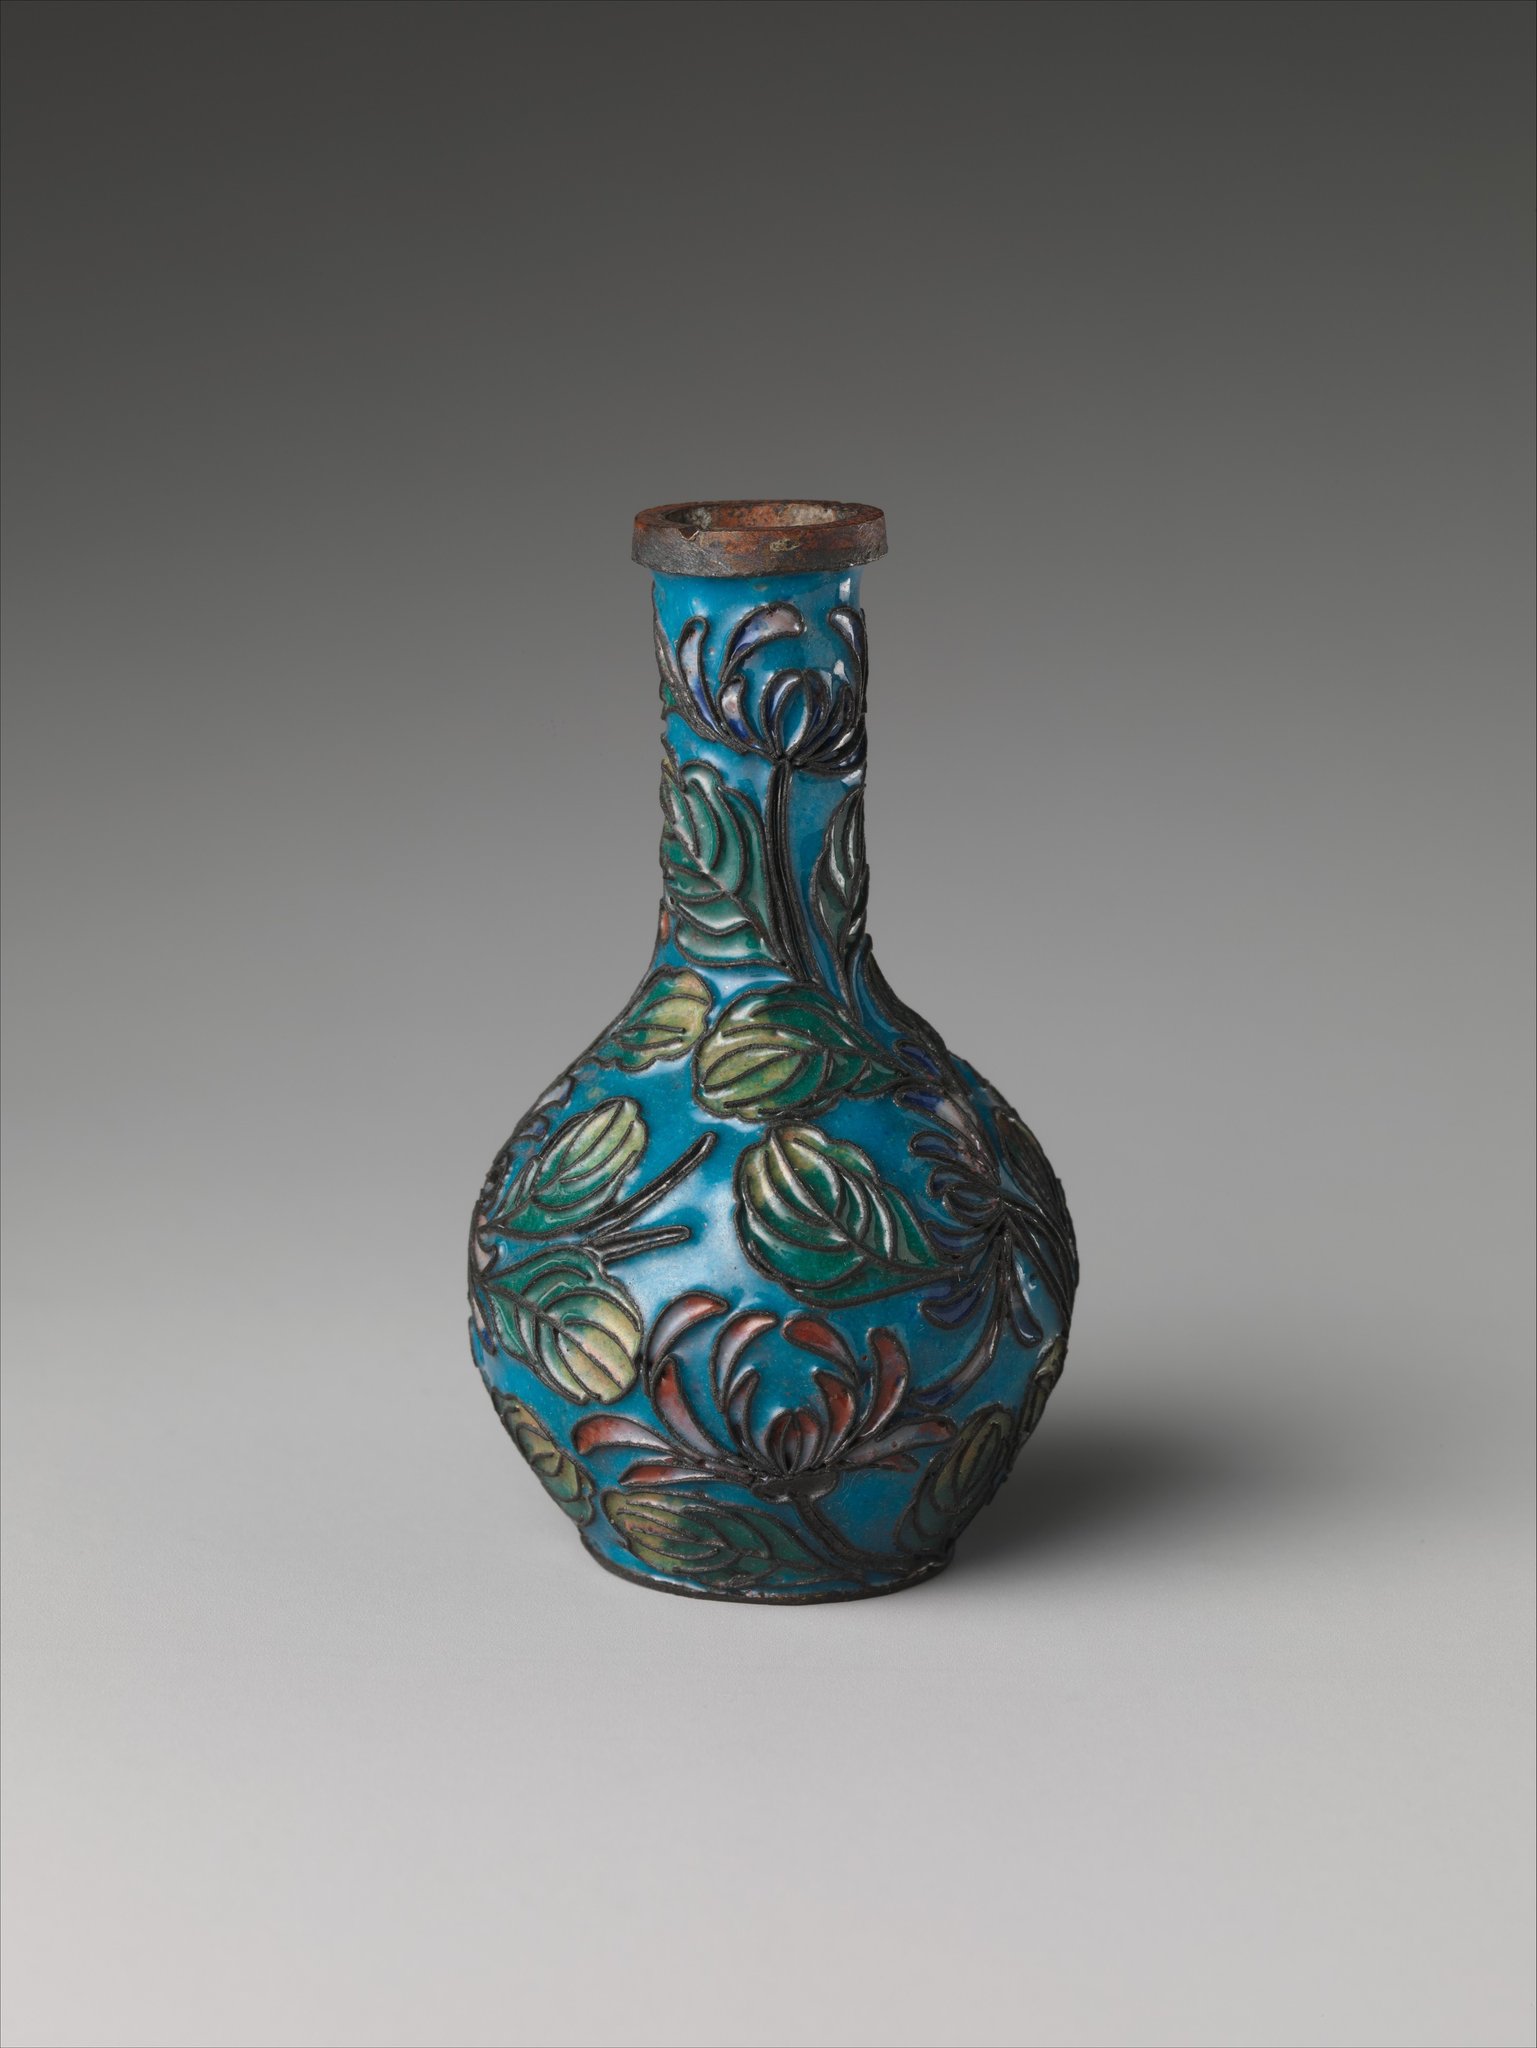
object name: vase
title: Vase from sample set of Chinese cloisonné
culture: chinese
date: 1867-1900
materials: copper alloy, enamel, glass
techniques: enamel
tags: leaves